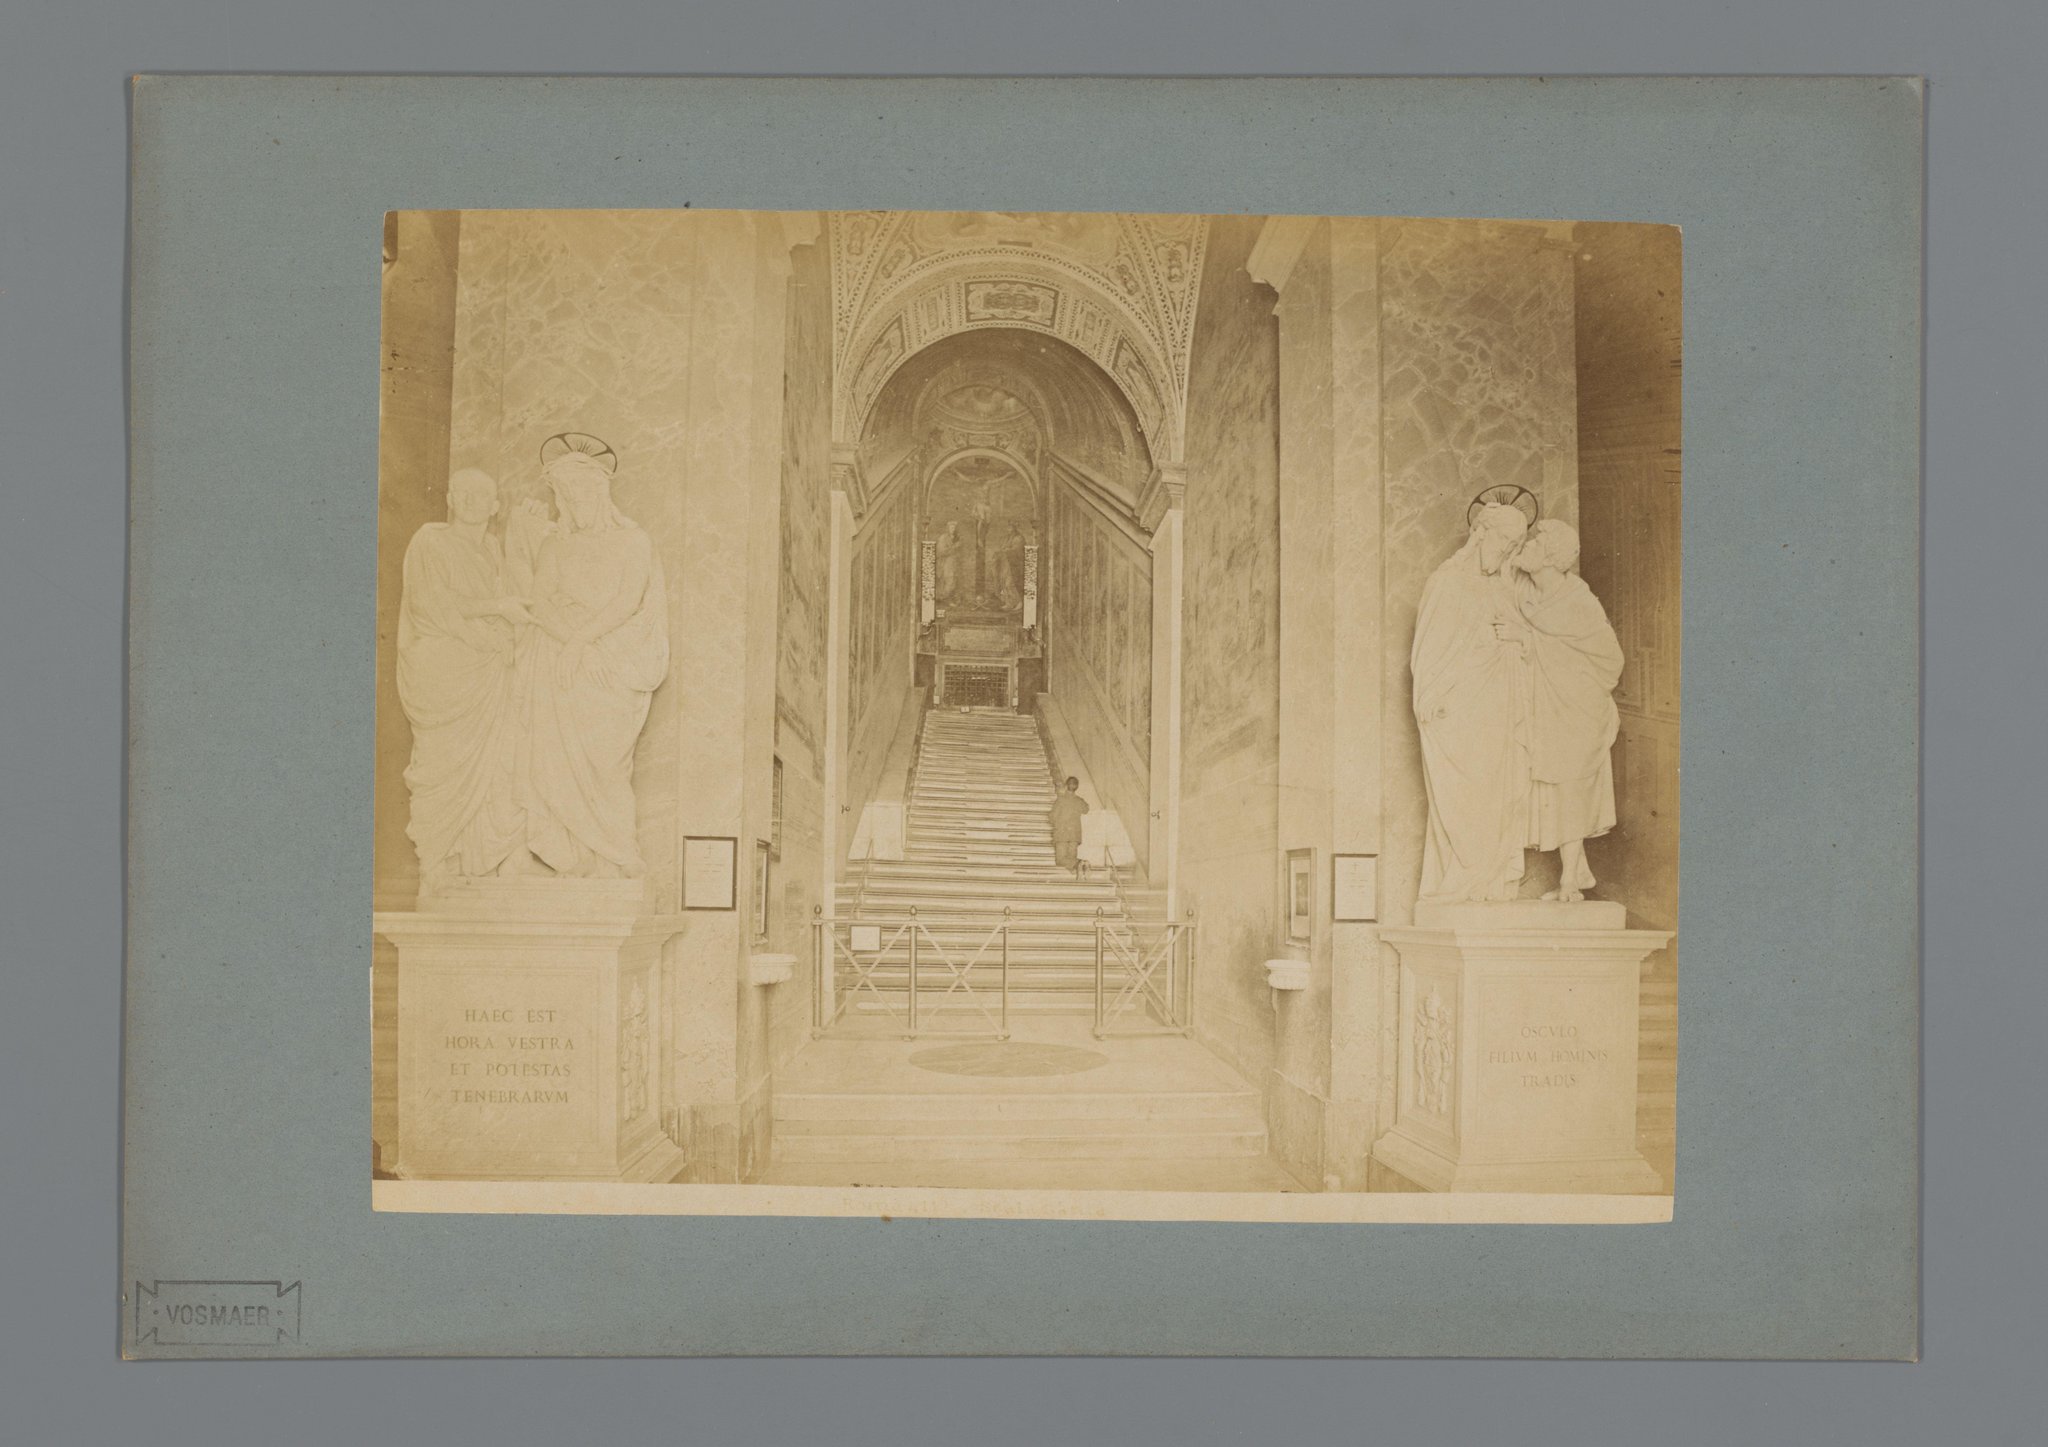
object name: photograph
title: Heilige Trap in het Lateraans paleis te Rome, Italië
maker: Anonymous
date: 1851-1890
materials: cardboard, paper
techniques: albumen print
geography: rome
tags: place of pilgrimage, sacred place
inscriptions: collector's mark: ‘VOSMAER’, number: ‘4112.’